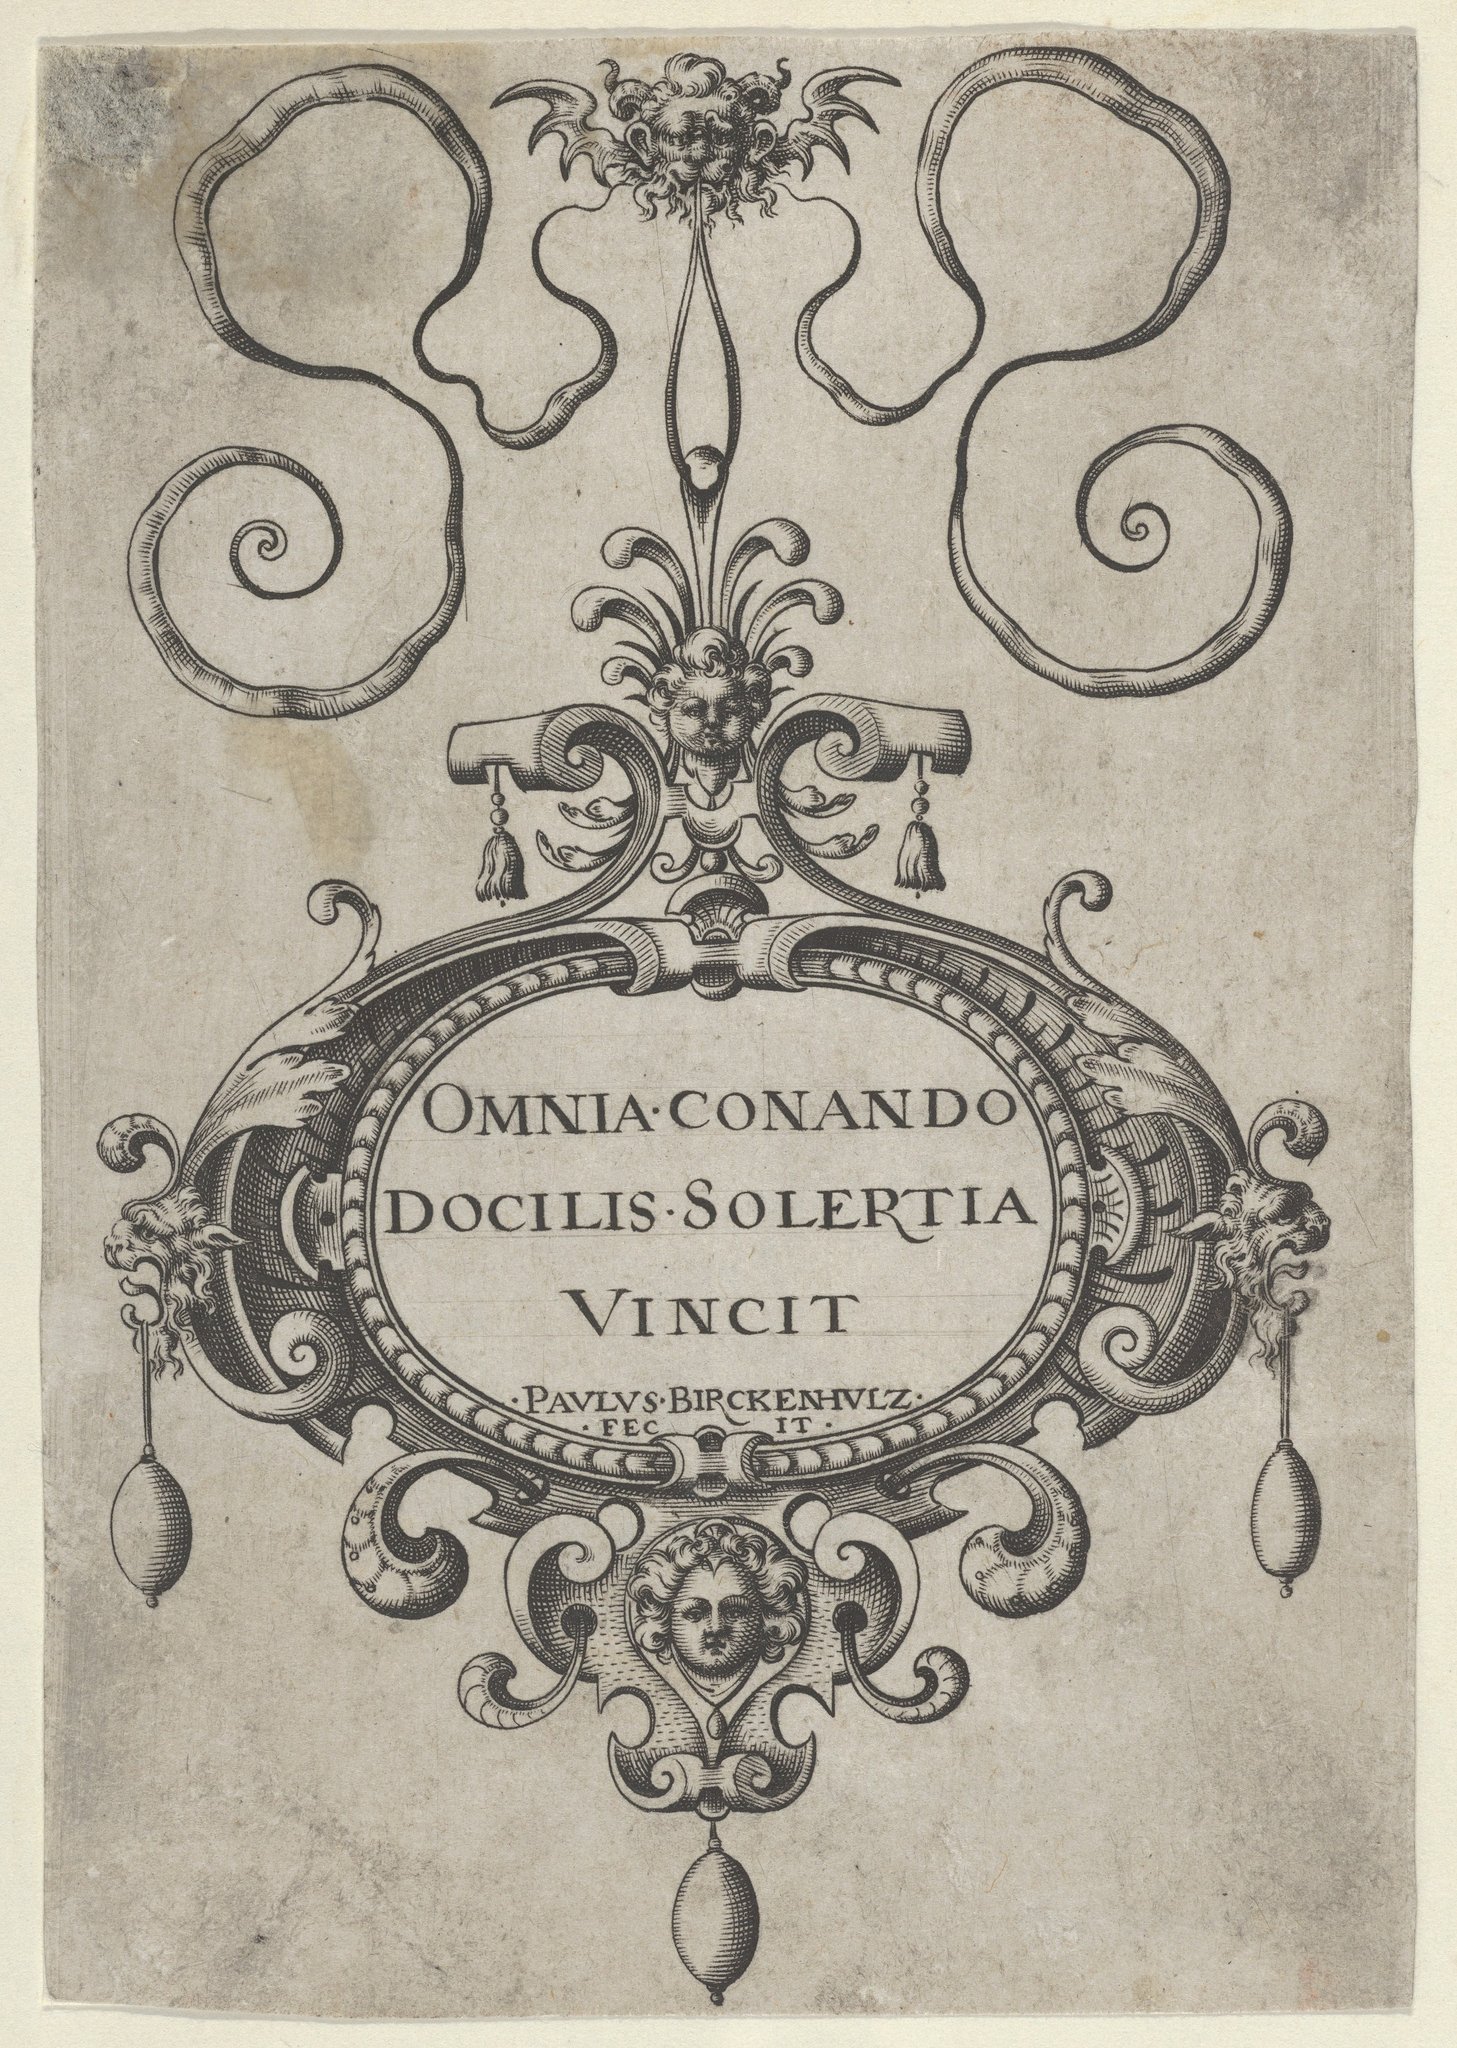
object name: print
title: Title Page, from "Omnia Conando Docilis Solertia Vincit"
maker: paul birckenhultz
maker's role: artist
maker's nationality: german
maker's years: 1561-1639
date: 1600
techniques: engraving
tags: masks,cartouches,faces